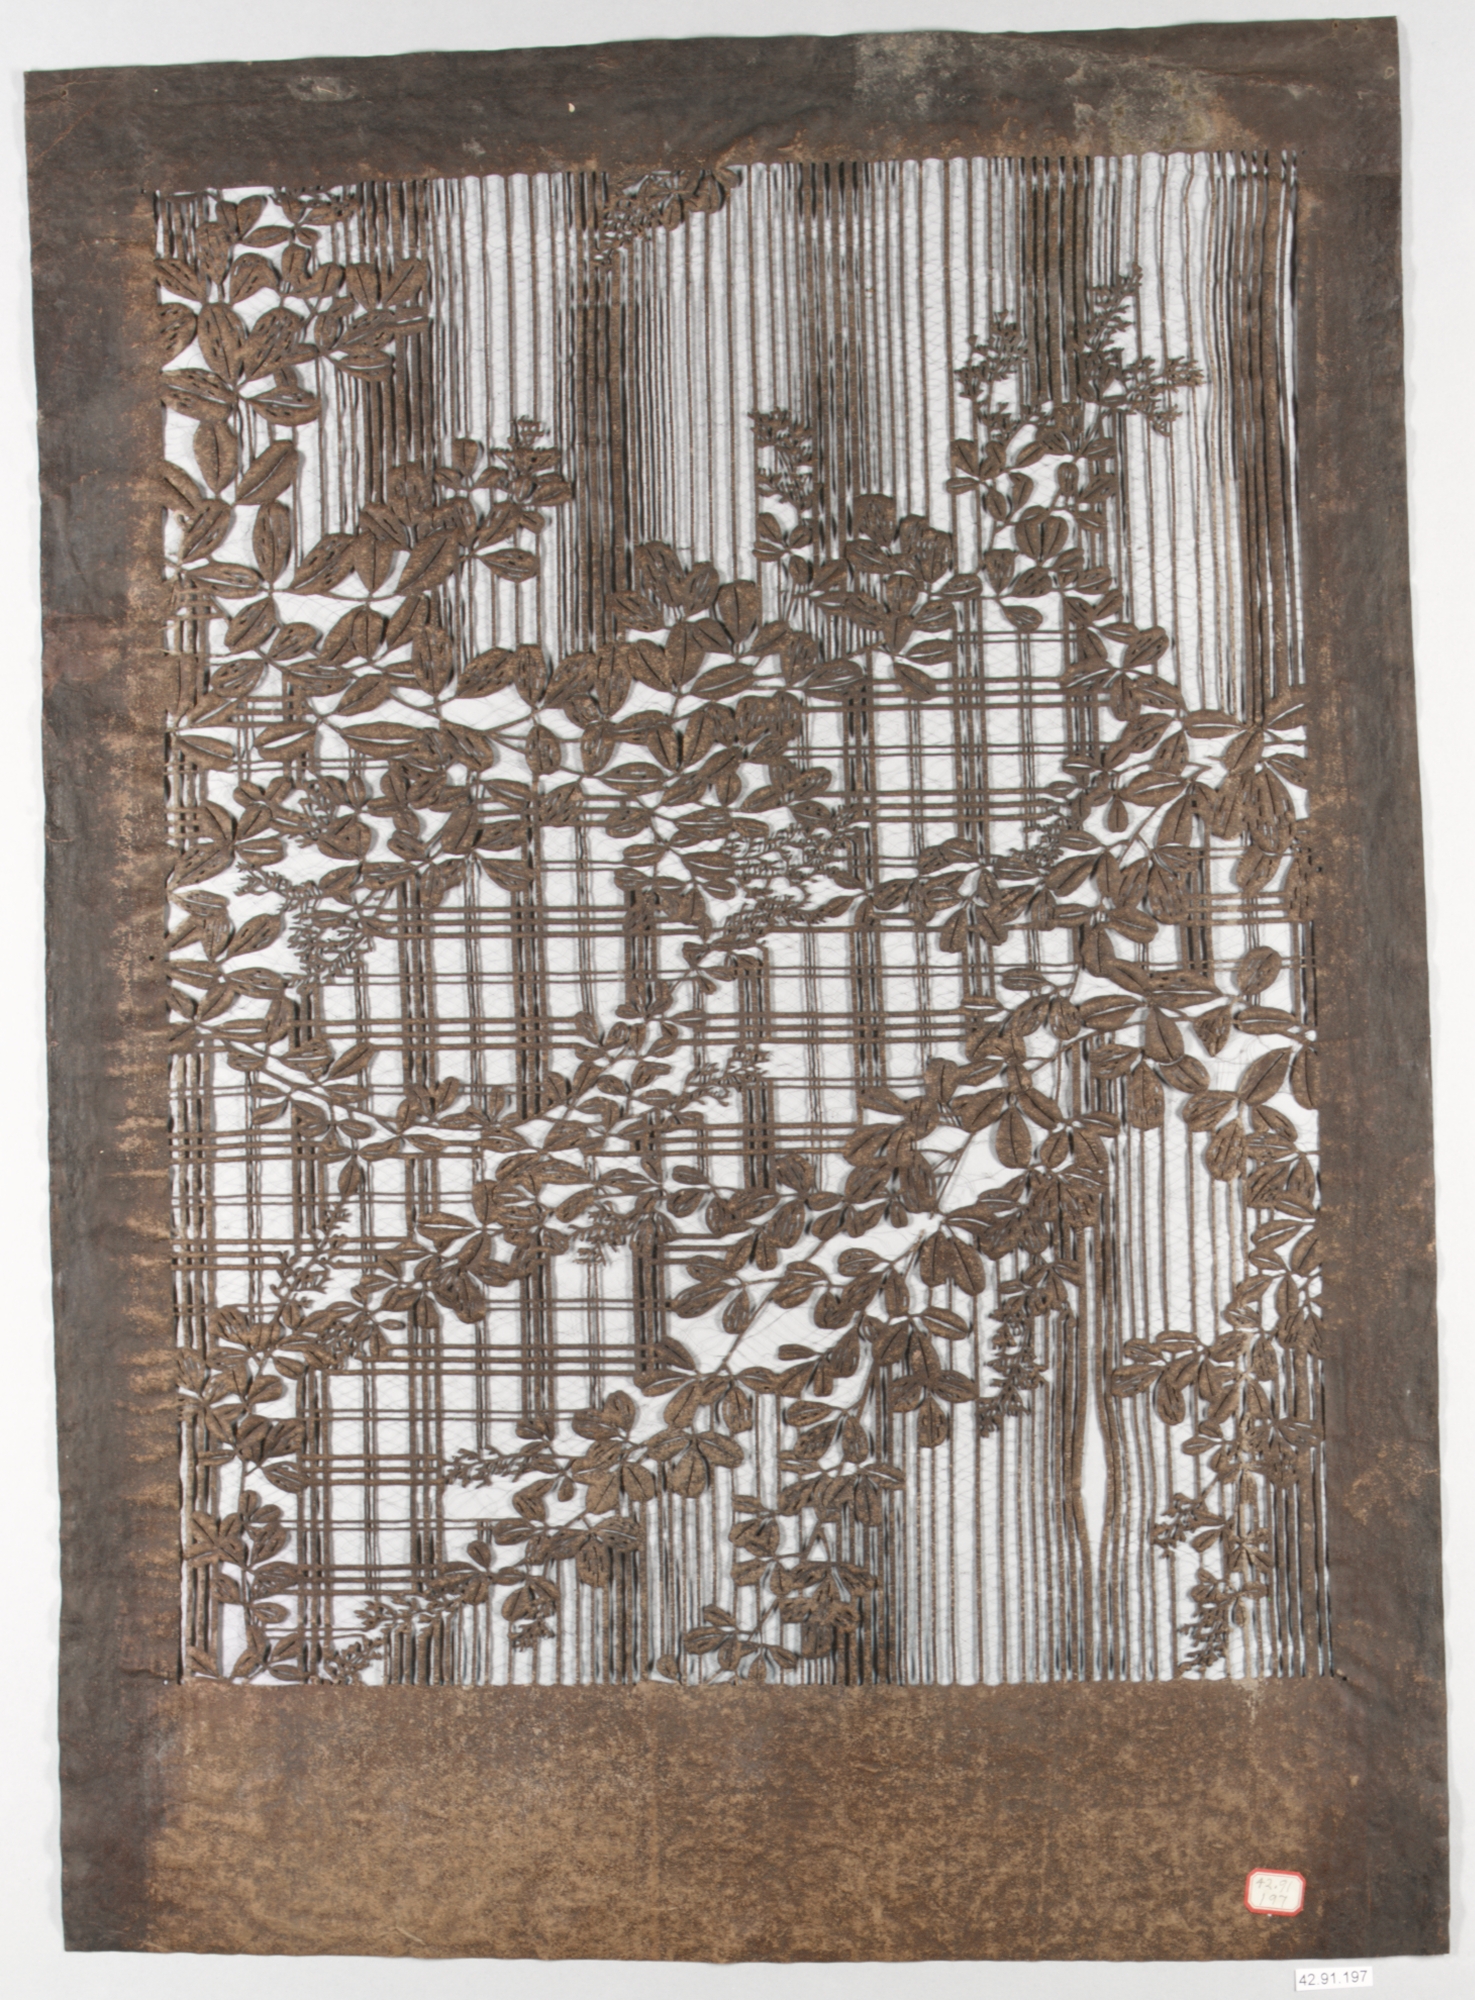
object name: stencil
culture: japanese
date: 1801-1900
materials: paper, silk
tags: plants